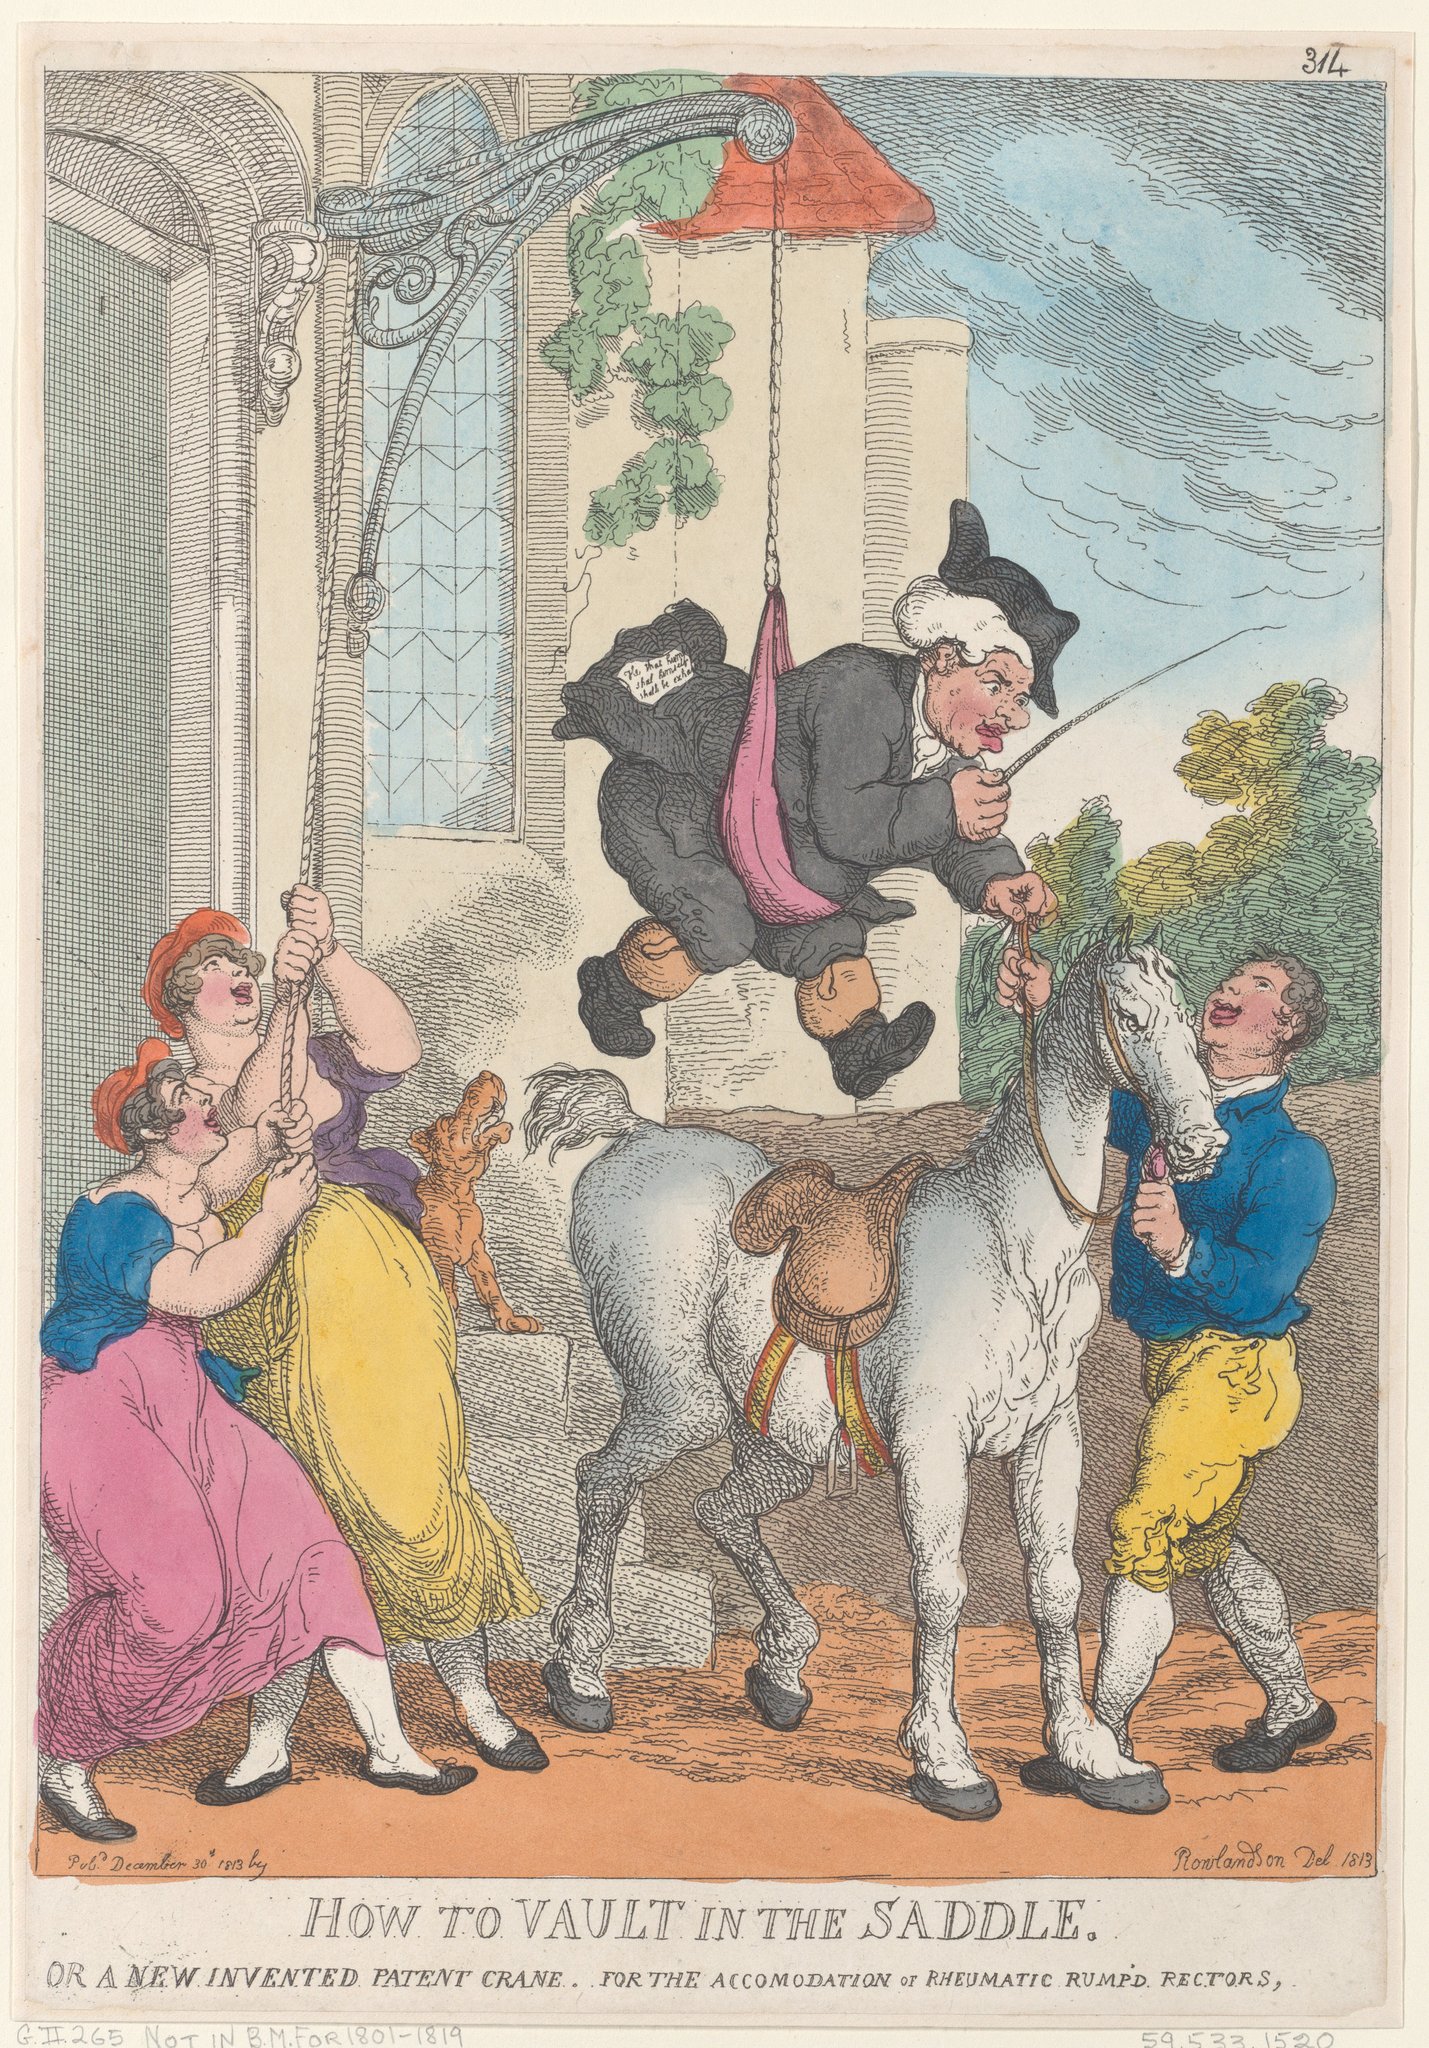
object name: print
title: How to Vault in the Saddle or a New Invented Patent Crane for the Accomodation or Rheumatic Rump'd Rectors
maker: thomas rowlandson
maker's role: artist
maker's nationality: british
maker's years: 1757-1827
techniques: etching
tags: satire,men,women,dogs,horses